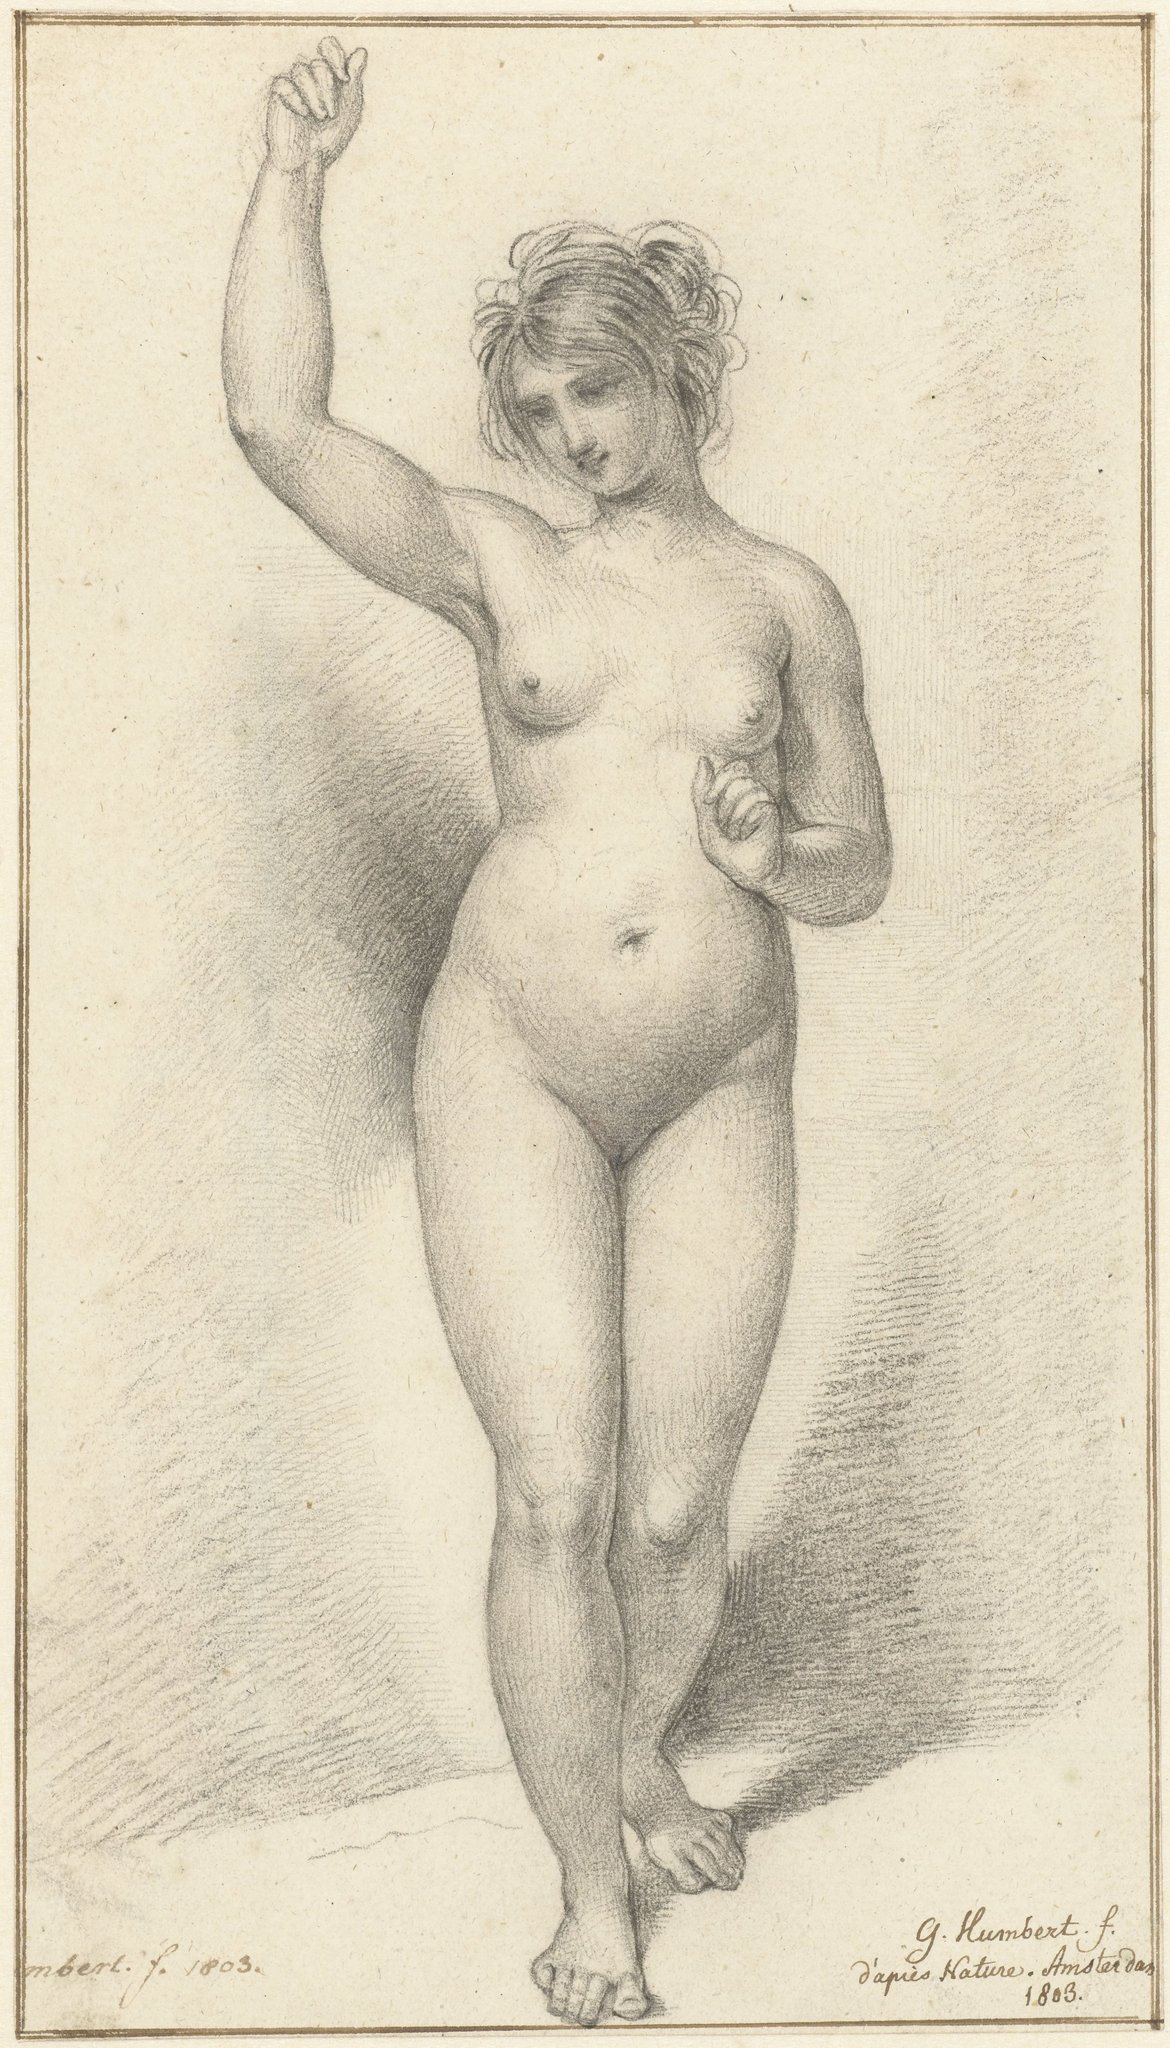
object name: drawing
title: Standing Female Nude, with Raised Right Arm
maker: david pièrre giottino humbert de superville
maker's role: draughtsman, painter, print maker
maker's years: 1770-1849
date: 1803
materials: chalk, paper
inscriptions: date: ‘1803’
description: De Superville used fine hatching to lend the body of this young women great volume. The pose, that is standing in contrapposto with one arm raised, is decidedly classical. To help models pose with their arm in the air as long as possible, special aids were used. The model in this drawing probably held onto a rope with her right hand, but this was omitted by the artist.